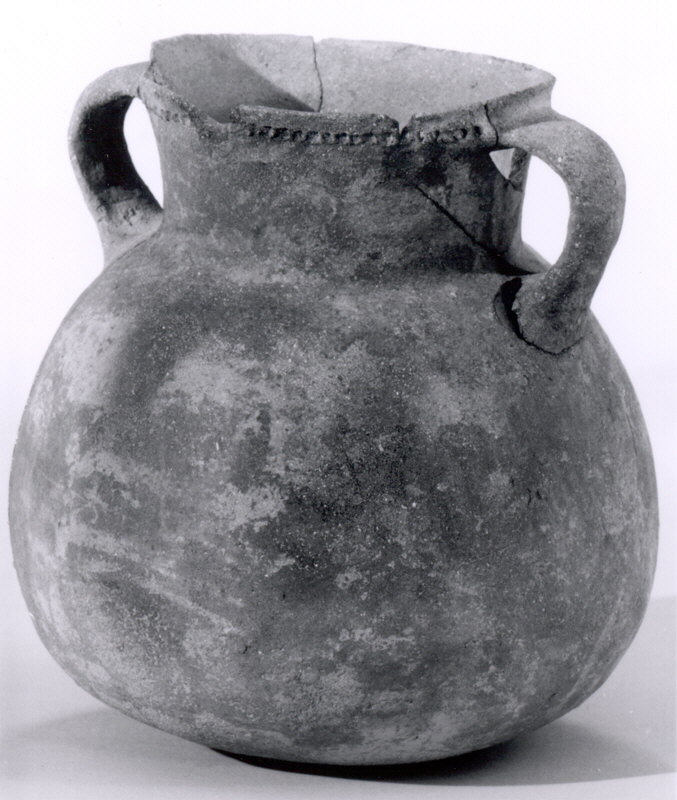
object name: jar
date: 3500-3300 BCE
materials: ceramic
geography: levant